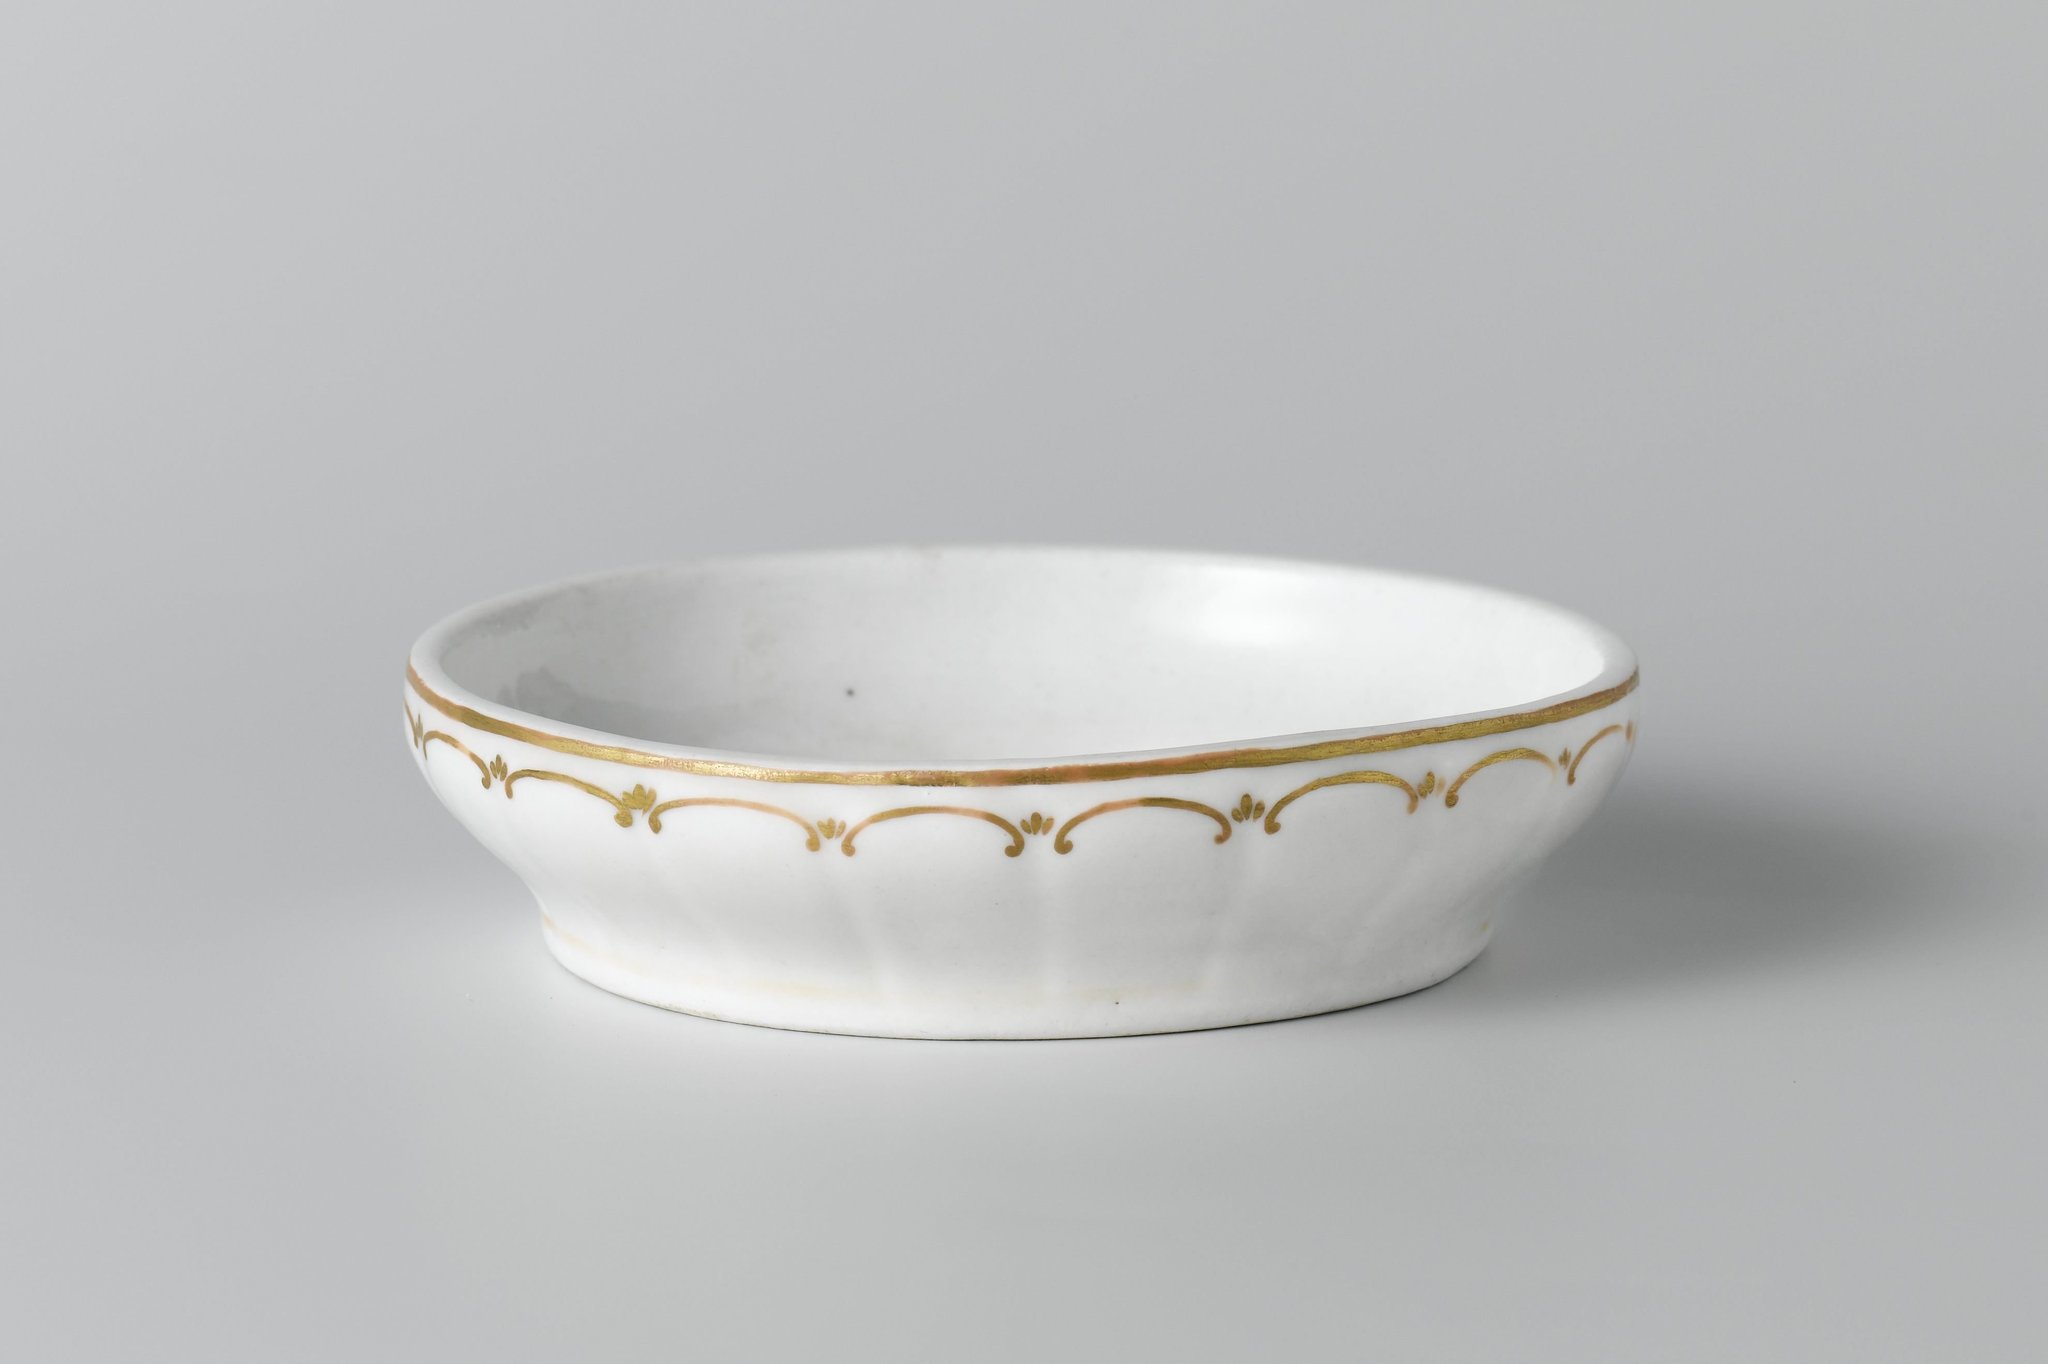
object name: platter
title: Two flowerpot containers (cache-pots) and stands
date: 1778-1782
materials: porcelain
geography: loosdrecht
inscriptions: factory mark: ‘M:OL’, mark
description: Manufactuur Oud-Loosdrecht Loosdrecht, c. 1778–1782 hard-paste porcelain